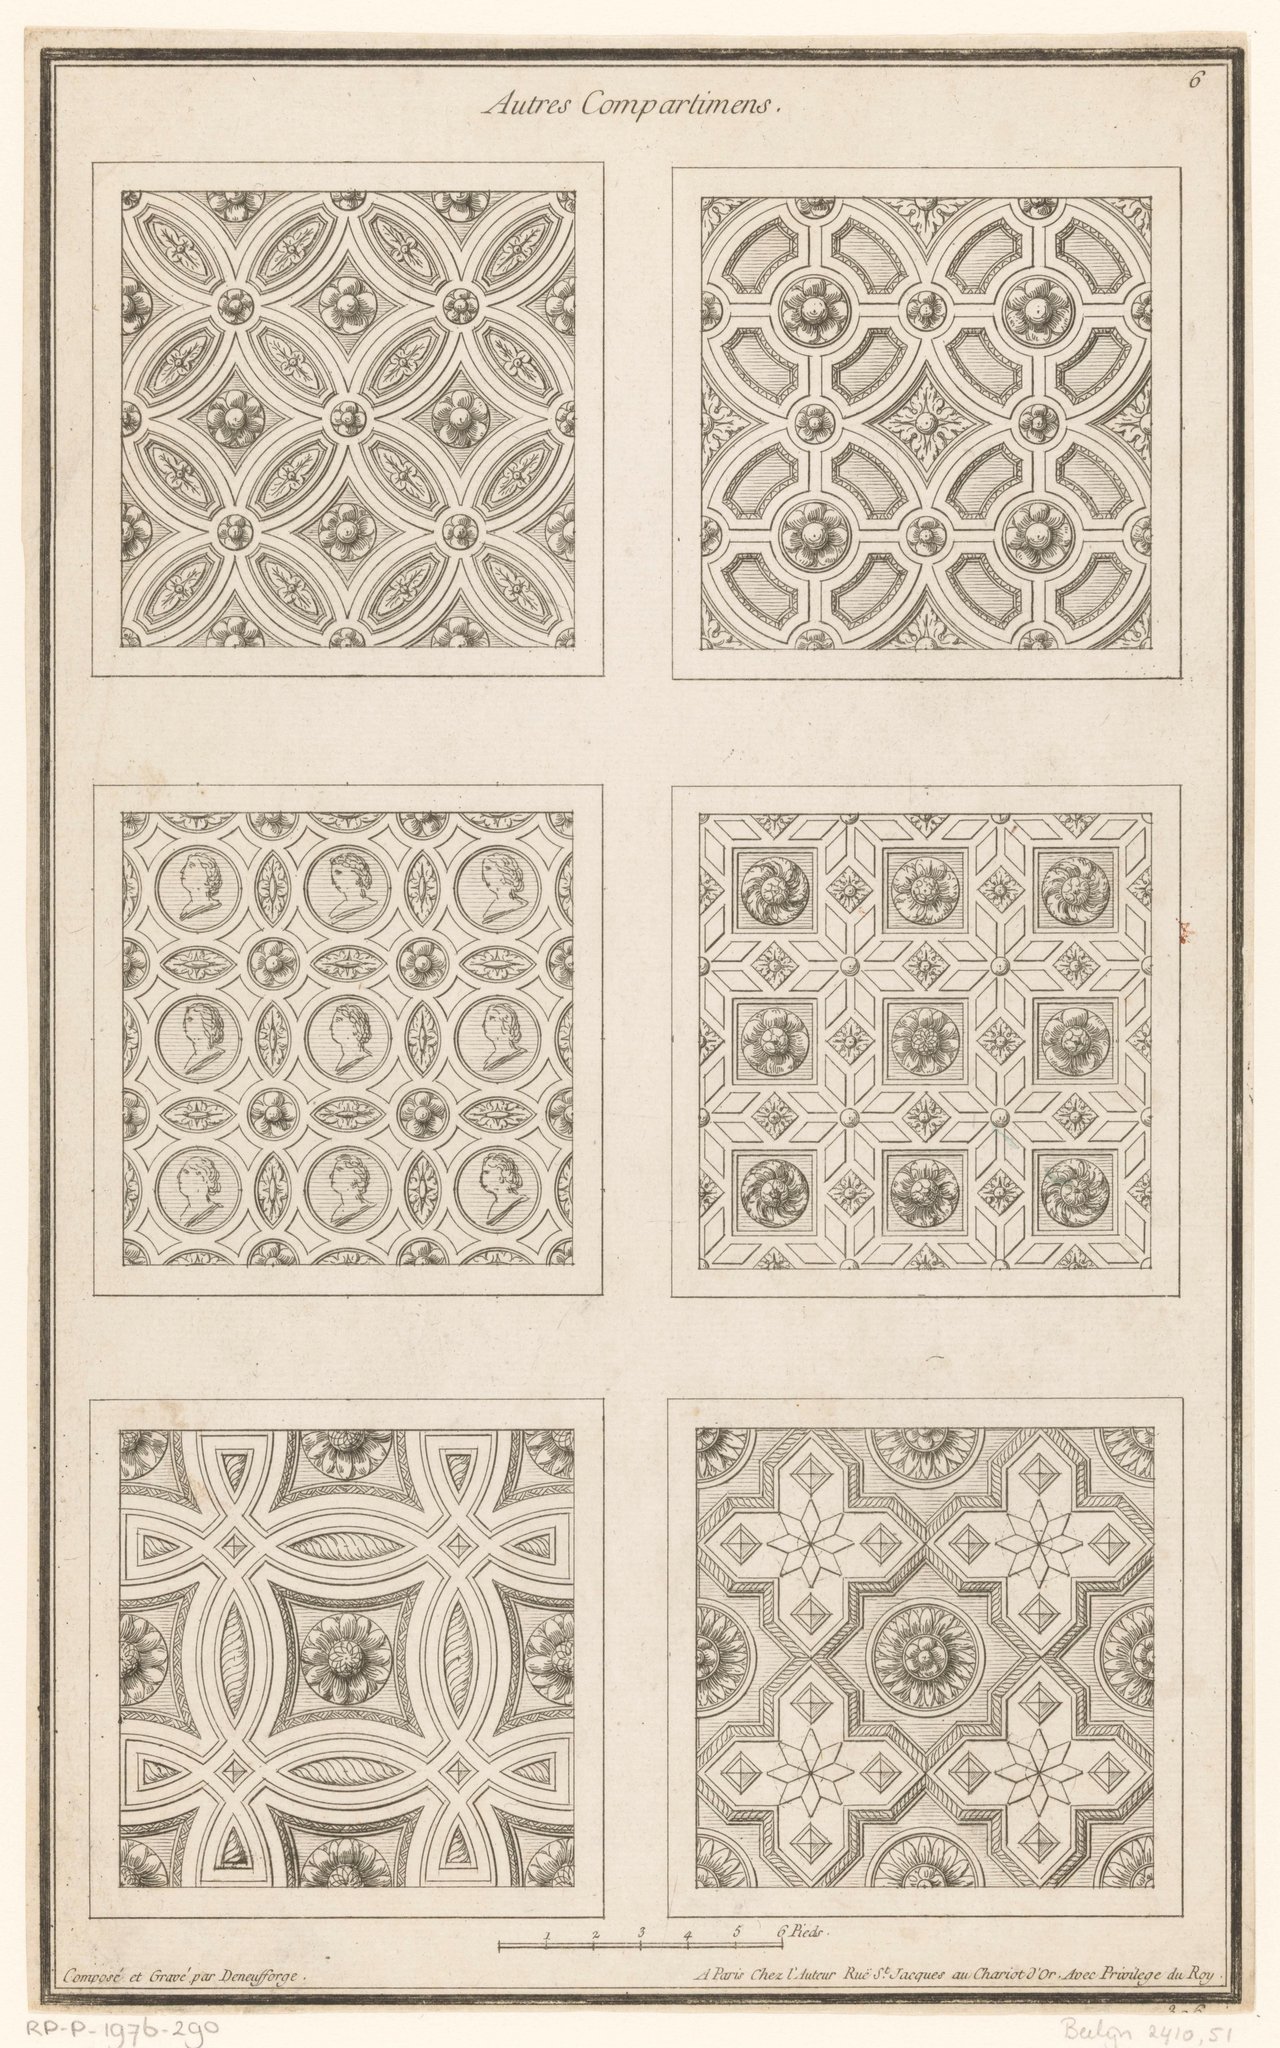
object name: ornament print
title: 51e Cayer Modéles pour diver Compartimens à l'Usage des Plafonds, Voutes et Parquets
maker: jean françois de neufforge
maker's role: print maker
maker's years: 1714-1791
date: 1763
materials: paper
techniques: etching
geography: paris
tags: (decorated) ceiling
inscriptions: collector's mark: Lugt 2228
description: Zes geornamenteerde plafonddelen met bloemmotieven, medaillons met portretten en stervormen. Prentnummer 306.